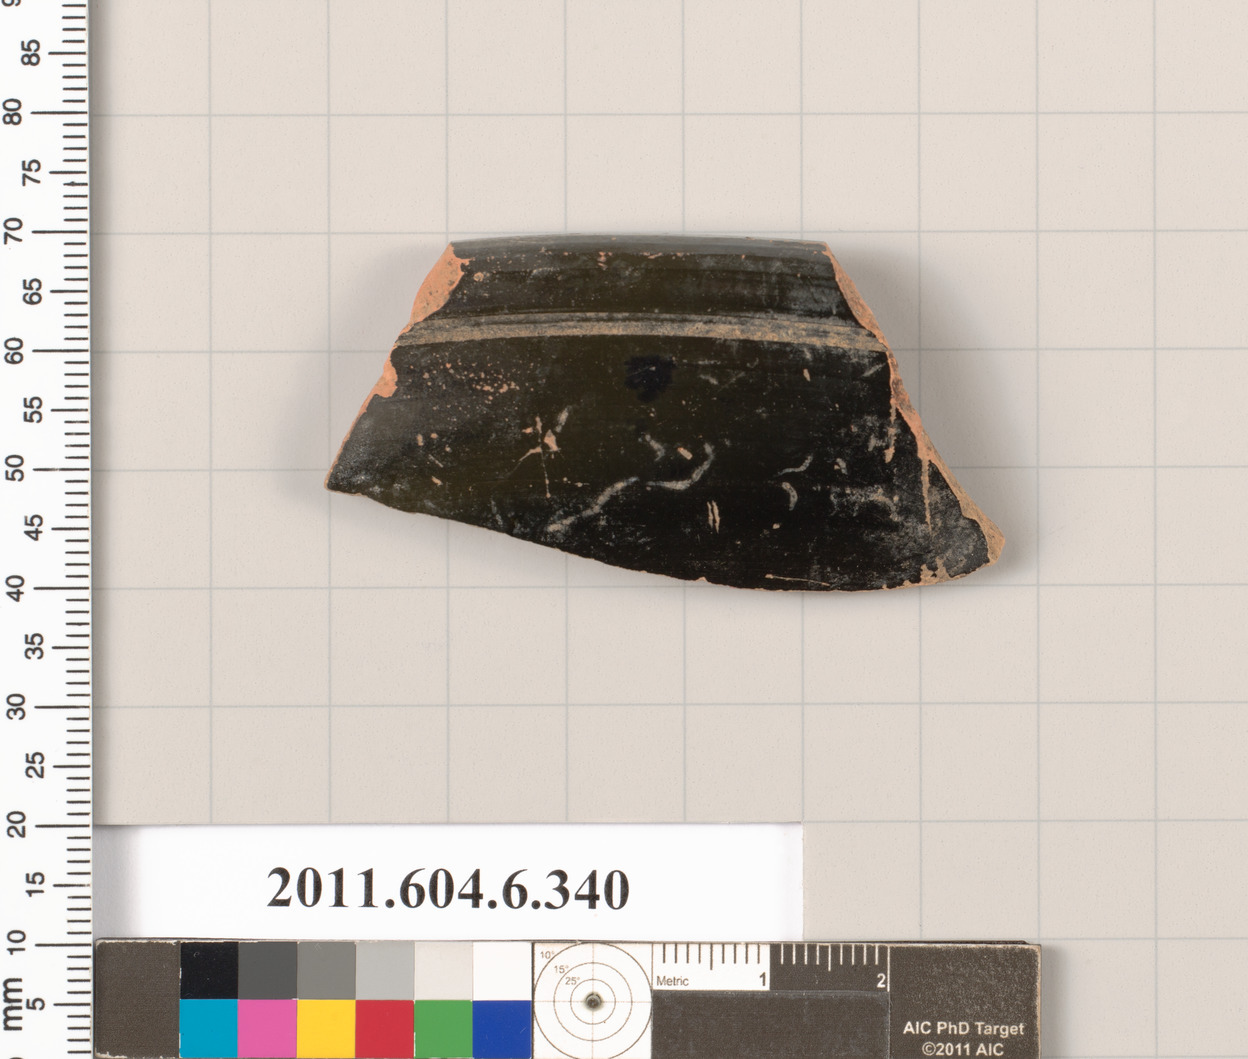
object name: fragment of a bowl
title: Terracotta rim fragment of a bowl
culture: greek, attic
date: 600-401 BCE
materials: terracotta